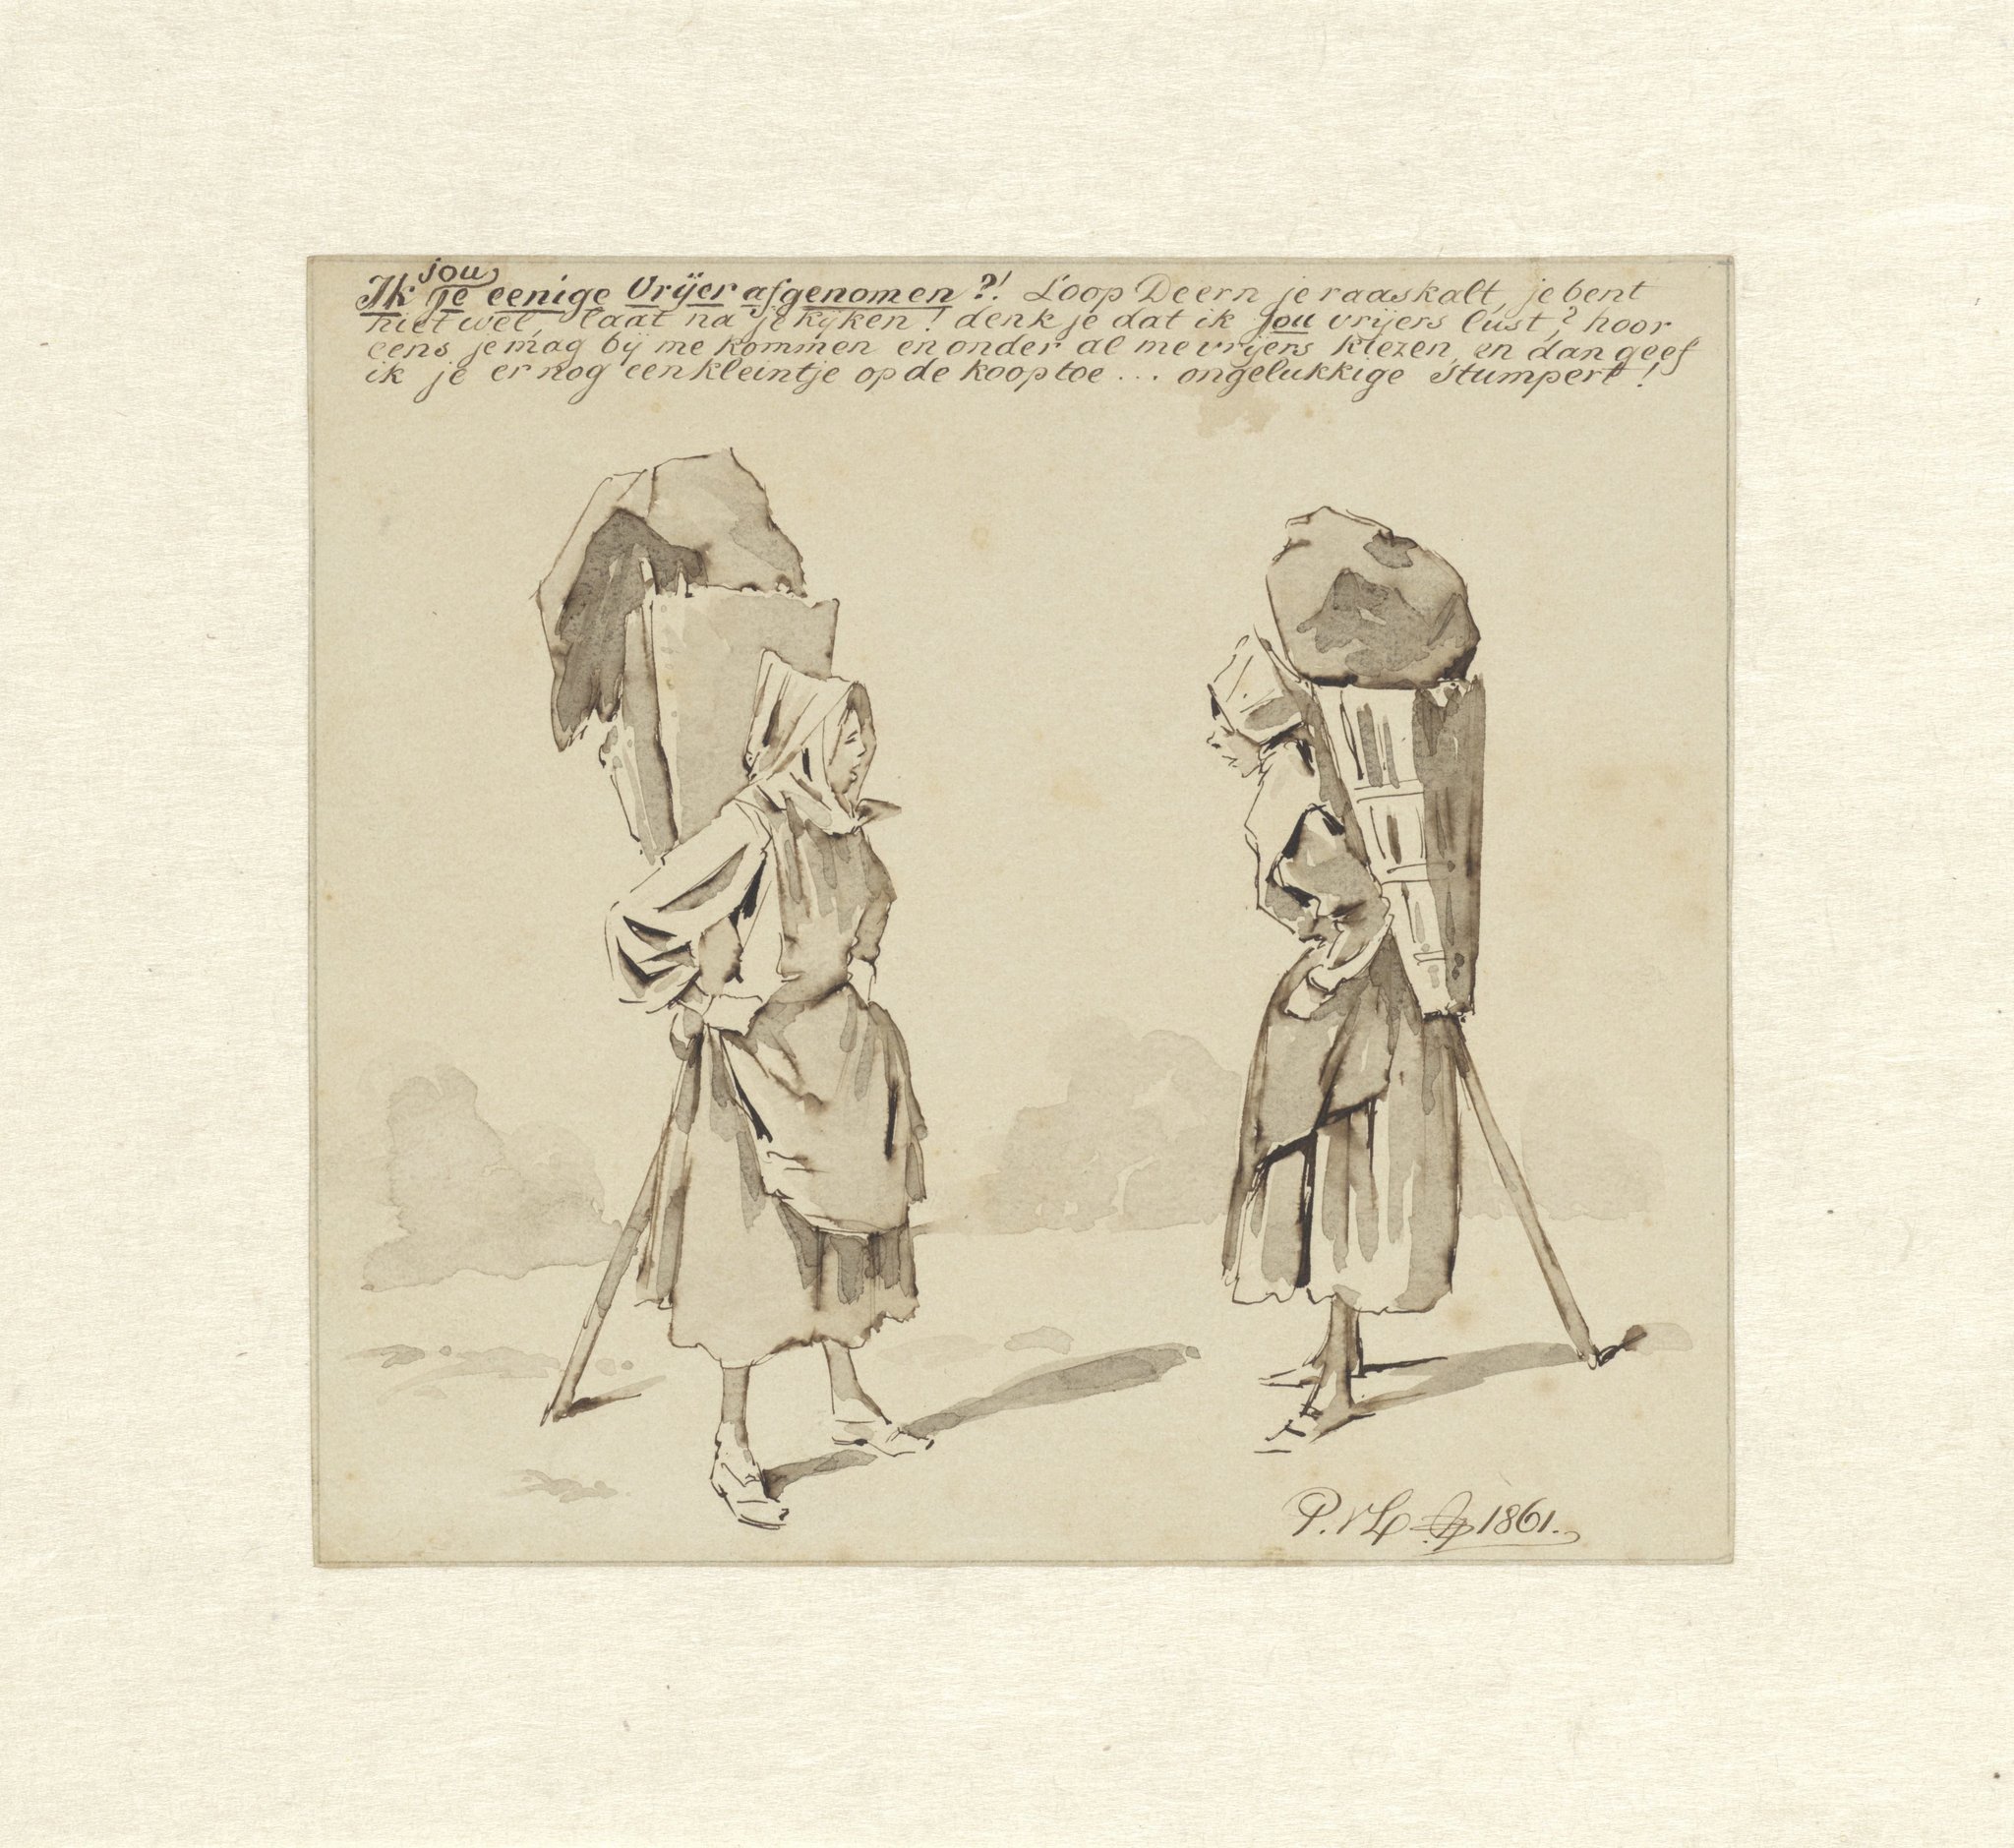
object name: caricature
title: Karikatuur van twee om een vrijer kijvende marktwijven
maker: pieter van loon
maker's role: draughtsman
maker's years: 1801-1873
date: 1861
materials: ink, paper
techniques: brush, pen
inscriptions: inscription: ‘Ik jou je eenige vrijer afgenomen?!...’, inscription